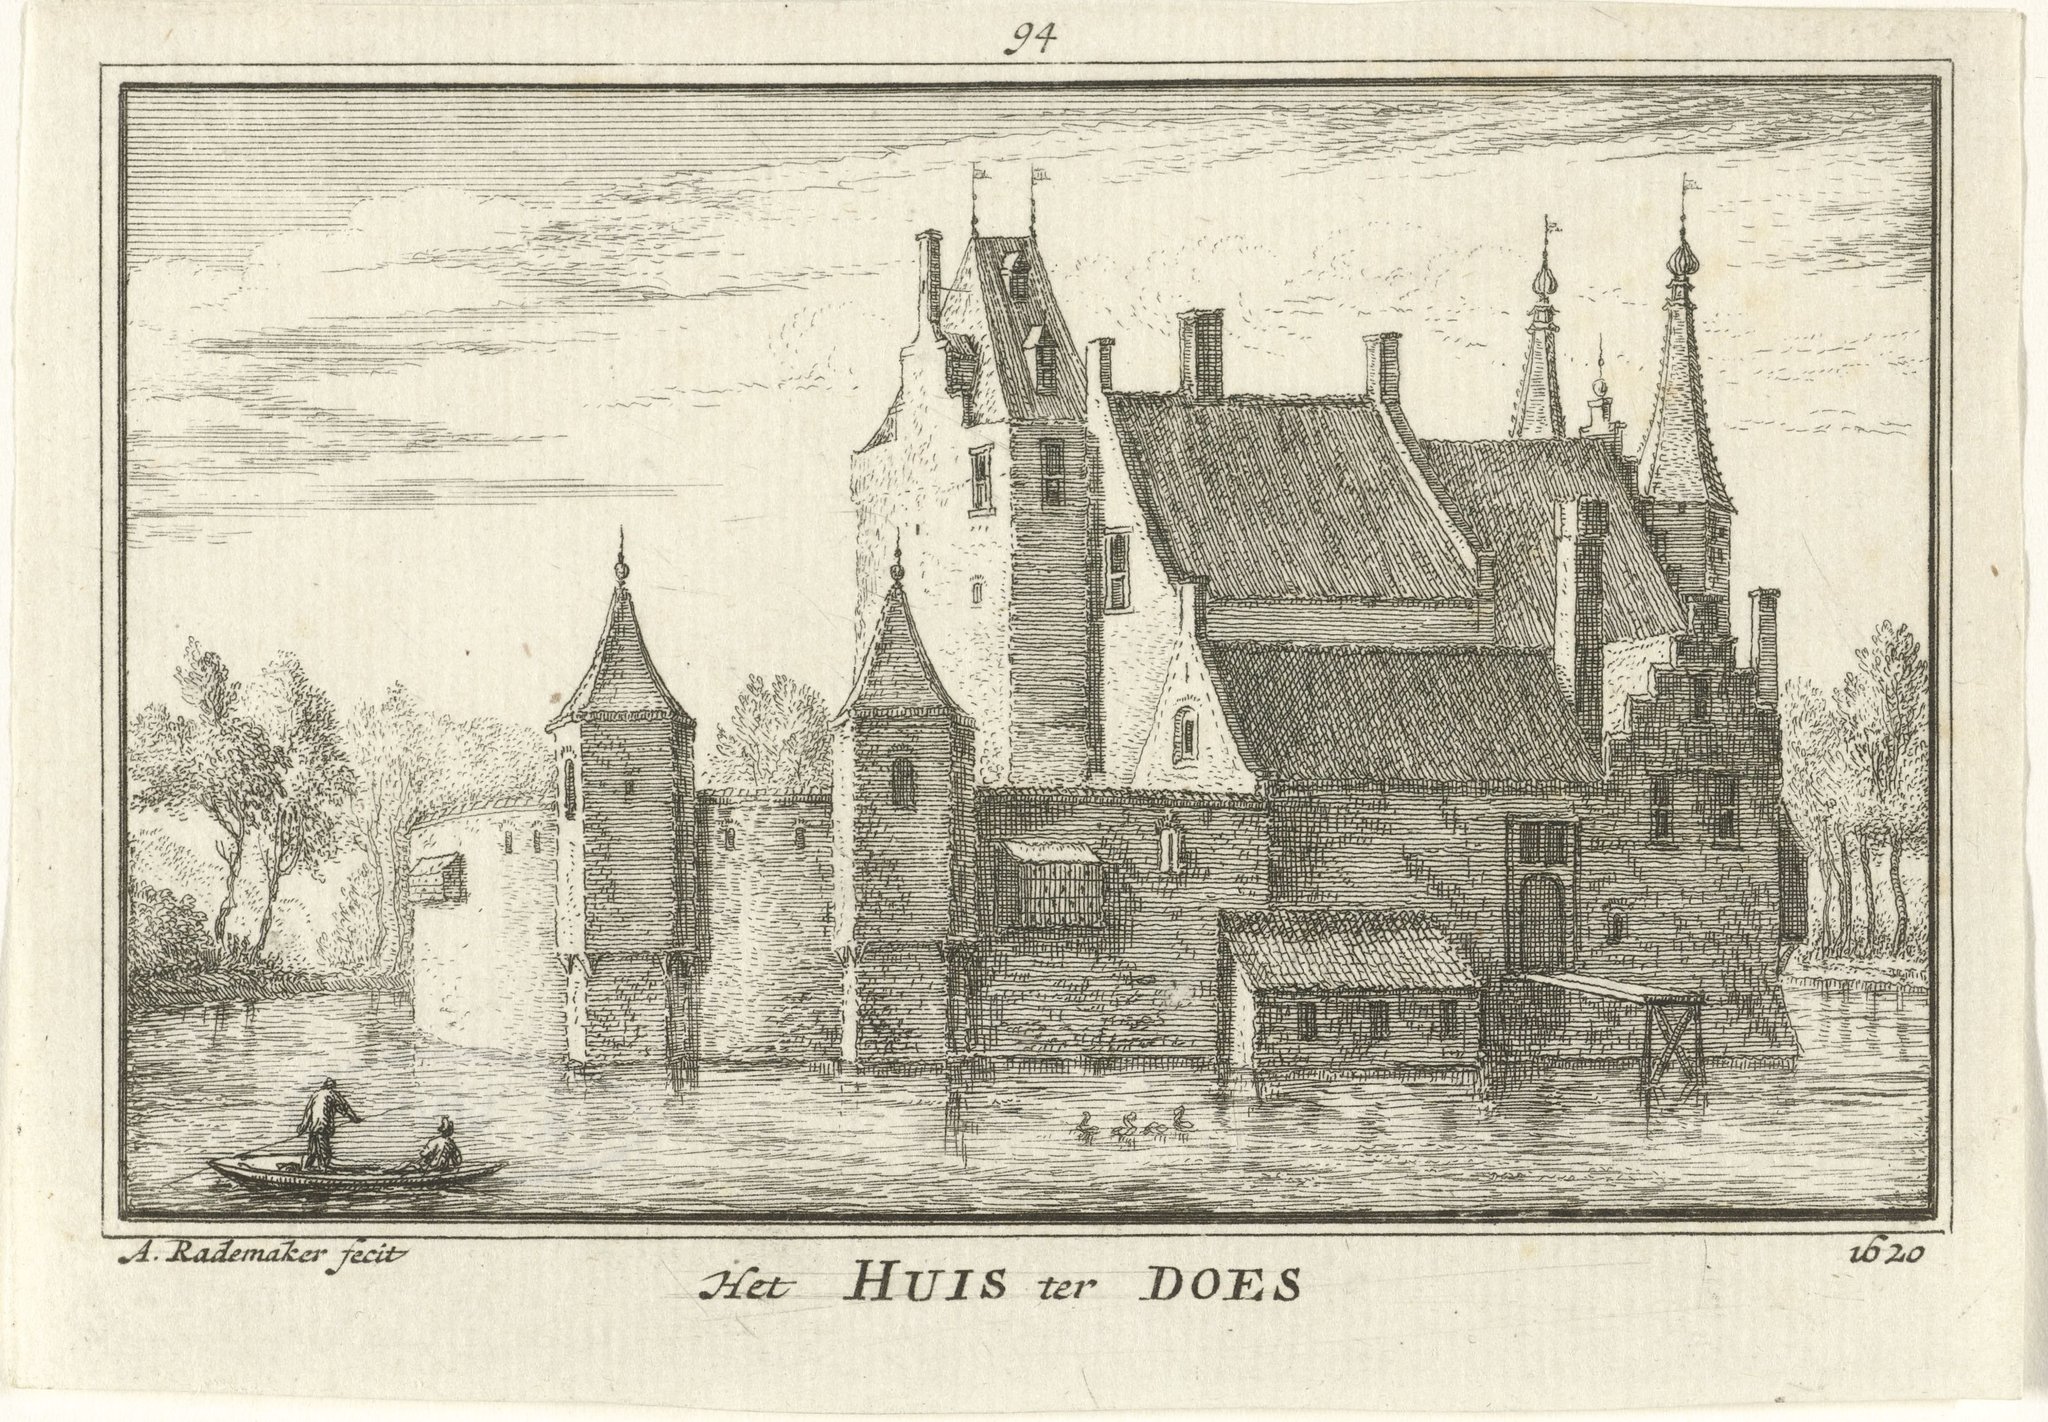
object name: print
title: Het Huis ter Does 1620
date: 1727-1733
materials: paper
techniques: etching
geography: amsterdam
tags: castle, fisherman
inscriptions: collector's mark: Lugt 2228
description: Illustratie uit: Abraham Rademaker, Matthaeus Brouërius van Niedek, Isaac Le Long, Kabinet van Nederlandsche en Kleefsche outheden en (...) voorname stads- en landgebouwen, Willem Barents en Antoni Schoonenburg: Amsterdam, 1727-1733, ill. nr. 94.